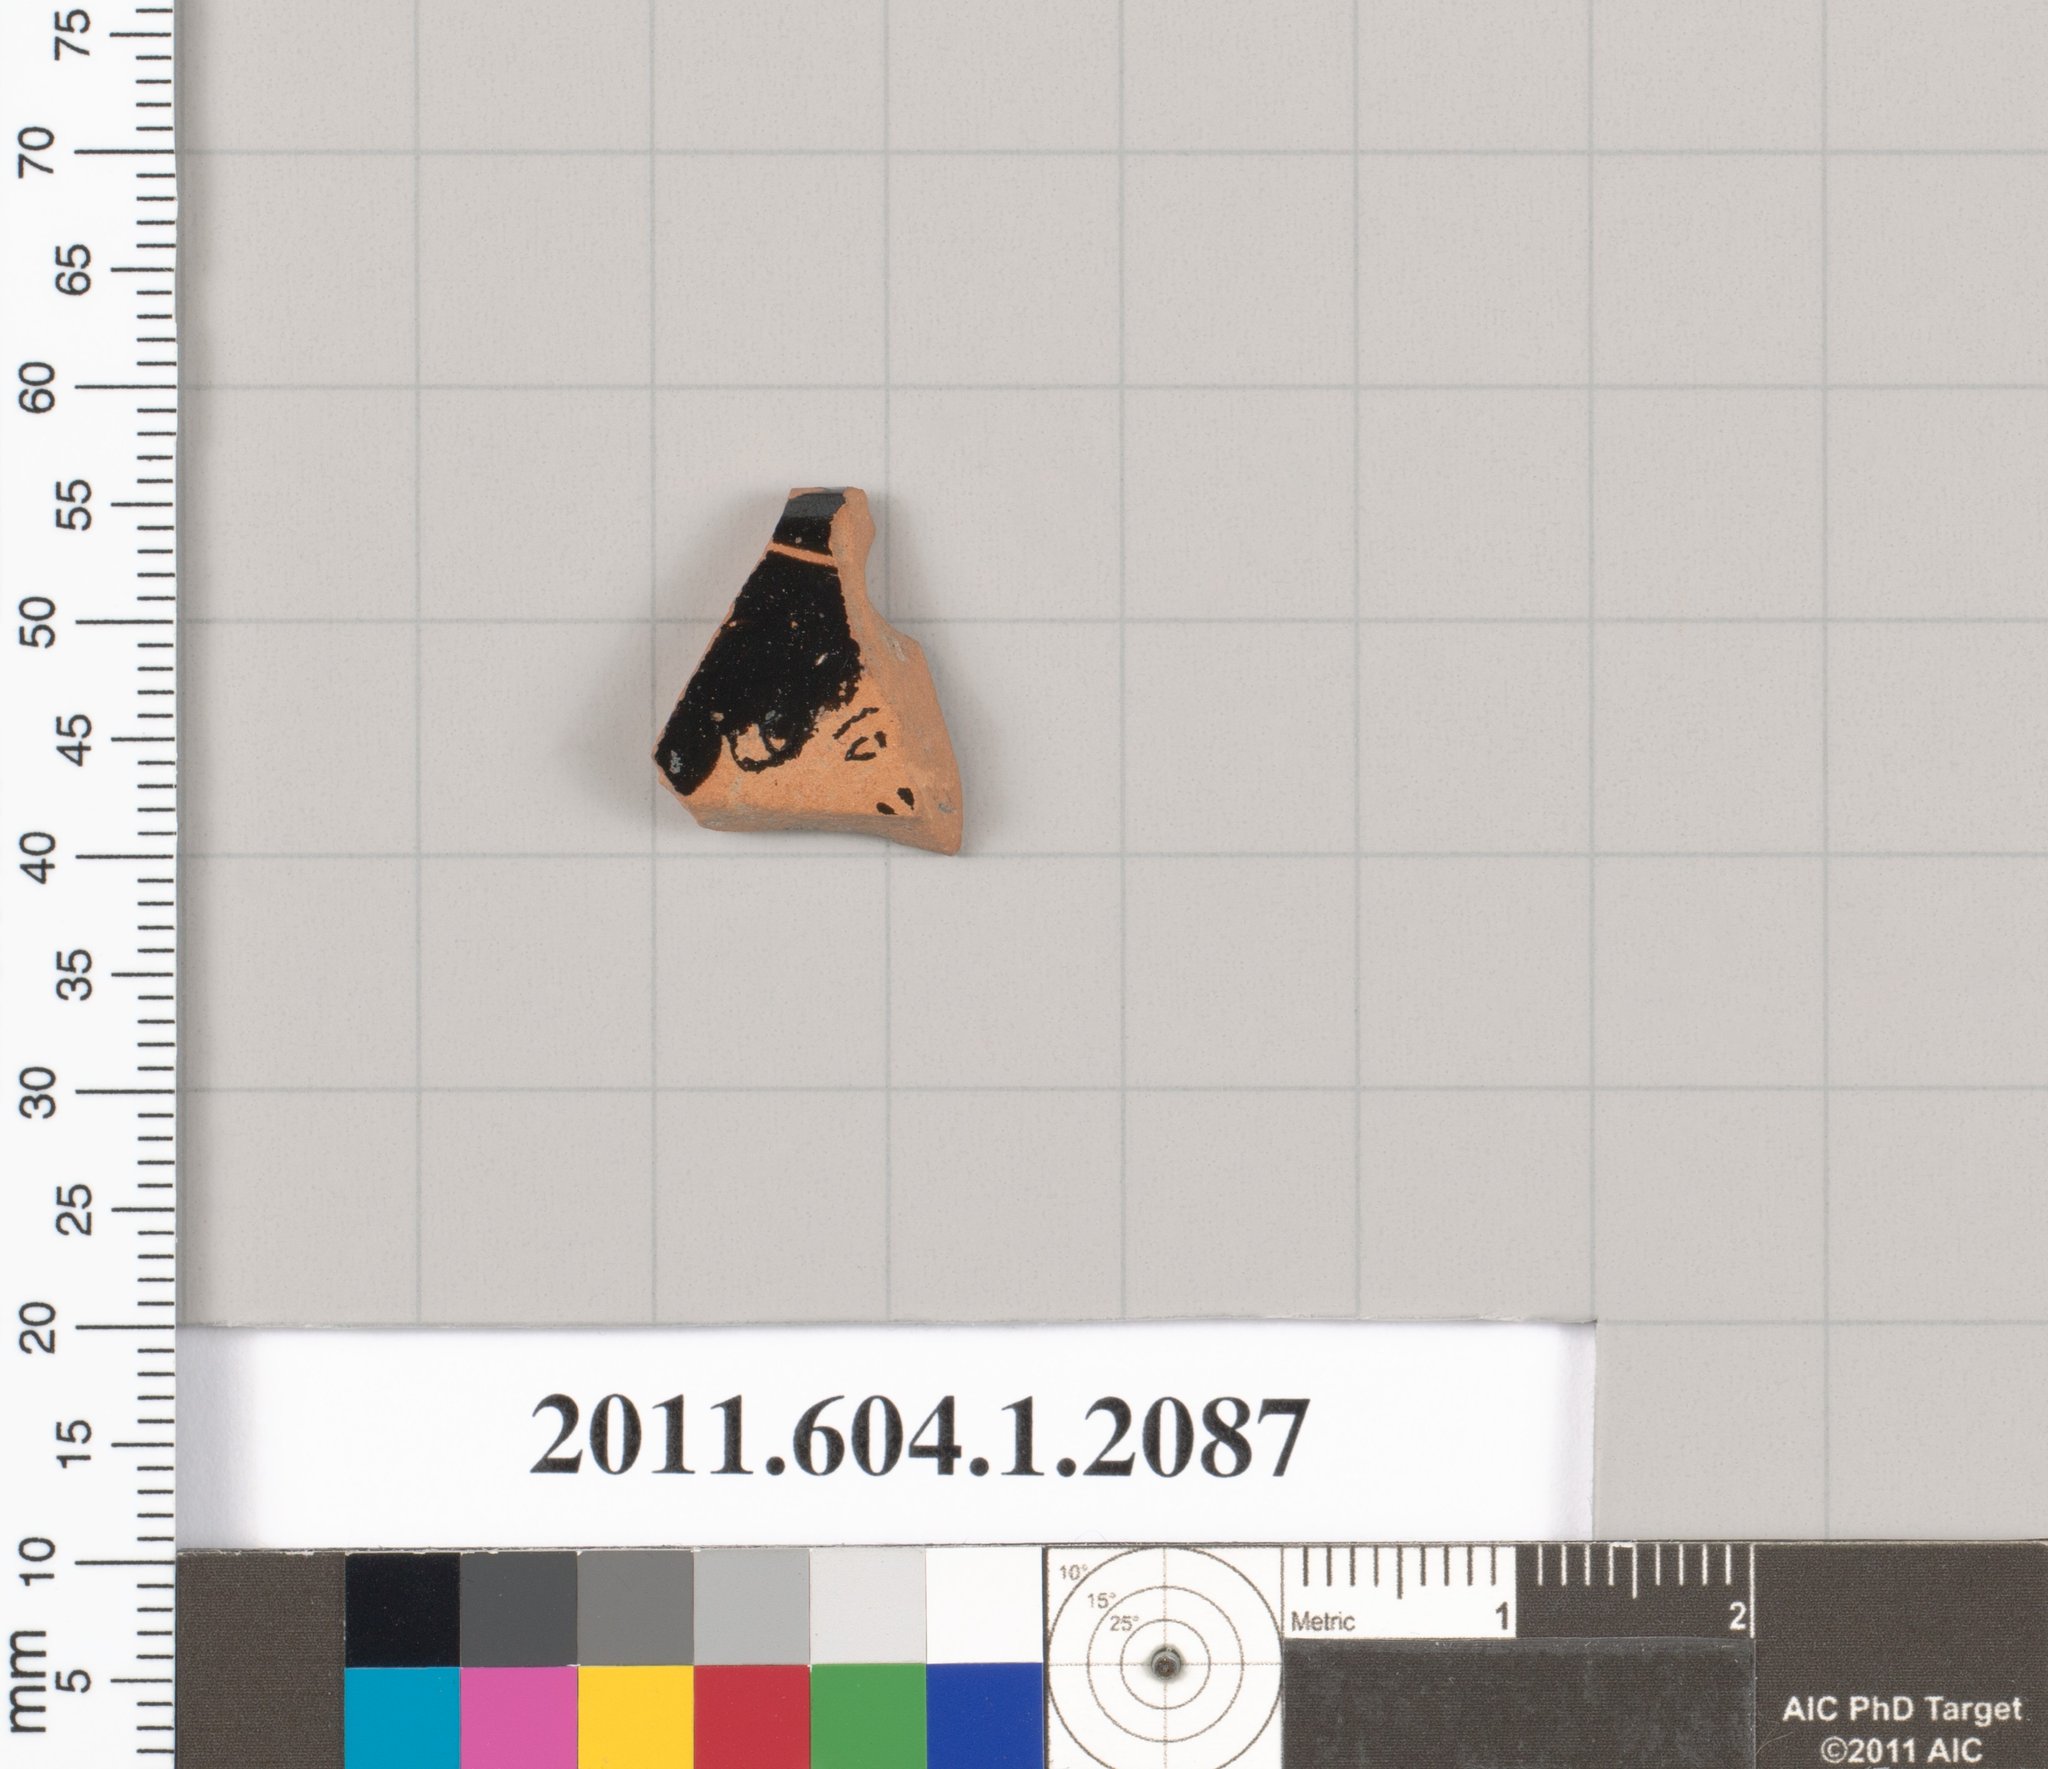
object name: kylix fragment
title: Terracotta rim fragment of a kylix (drinking cup)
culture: greek, attic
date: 434-466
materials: terracotta